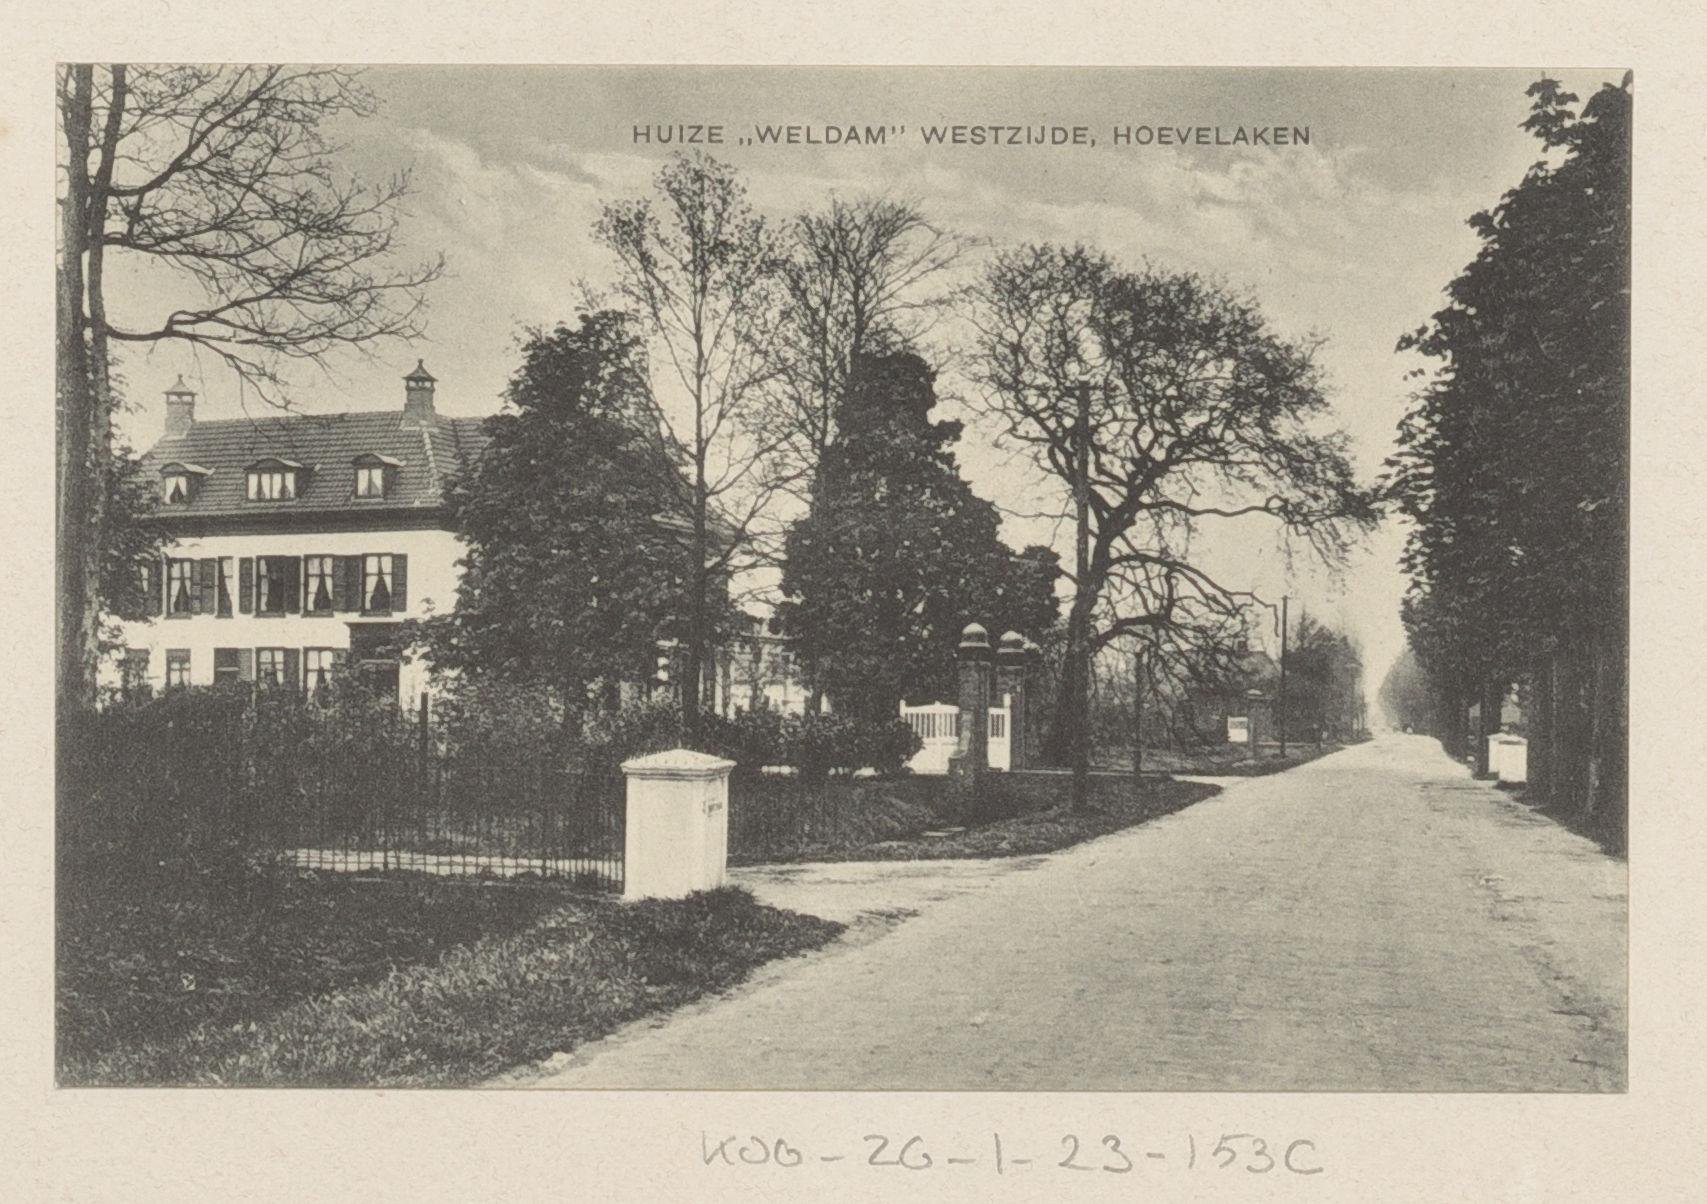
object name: photomechanical print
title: Zijaanzicht van de westkant van buitenplaats Weldam te Hoevelaken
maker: Anonymous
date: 1905-1930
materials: paper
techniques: photograph, letterpress printing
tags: country-house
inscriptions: stamp, collector's mark: Lugt 1641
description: Onderwerpsrubrieken binnen de Atlas Zeden en Gewoonten: Zeden en gewoonten in Engeren zin, De woning, Kastelen en buitenplaatsen.